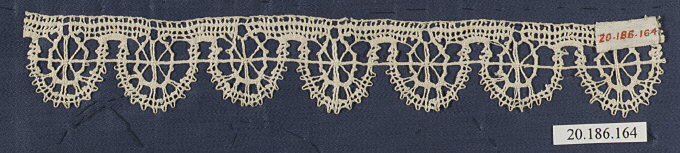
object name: edging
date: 1601-1700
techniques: lace